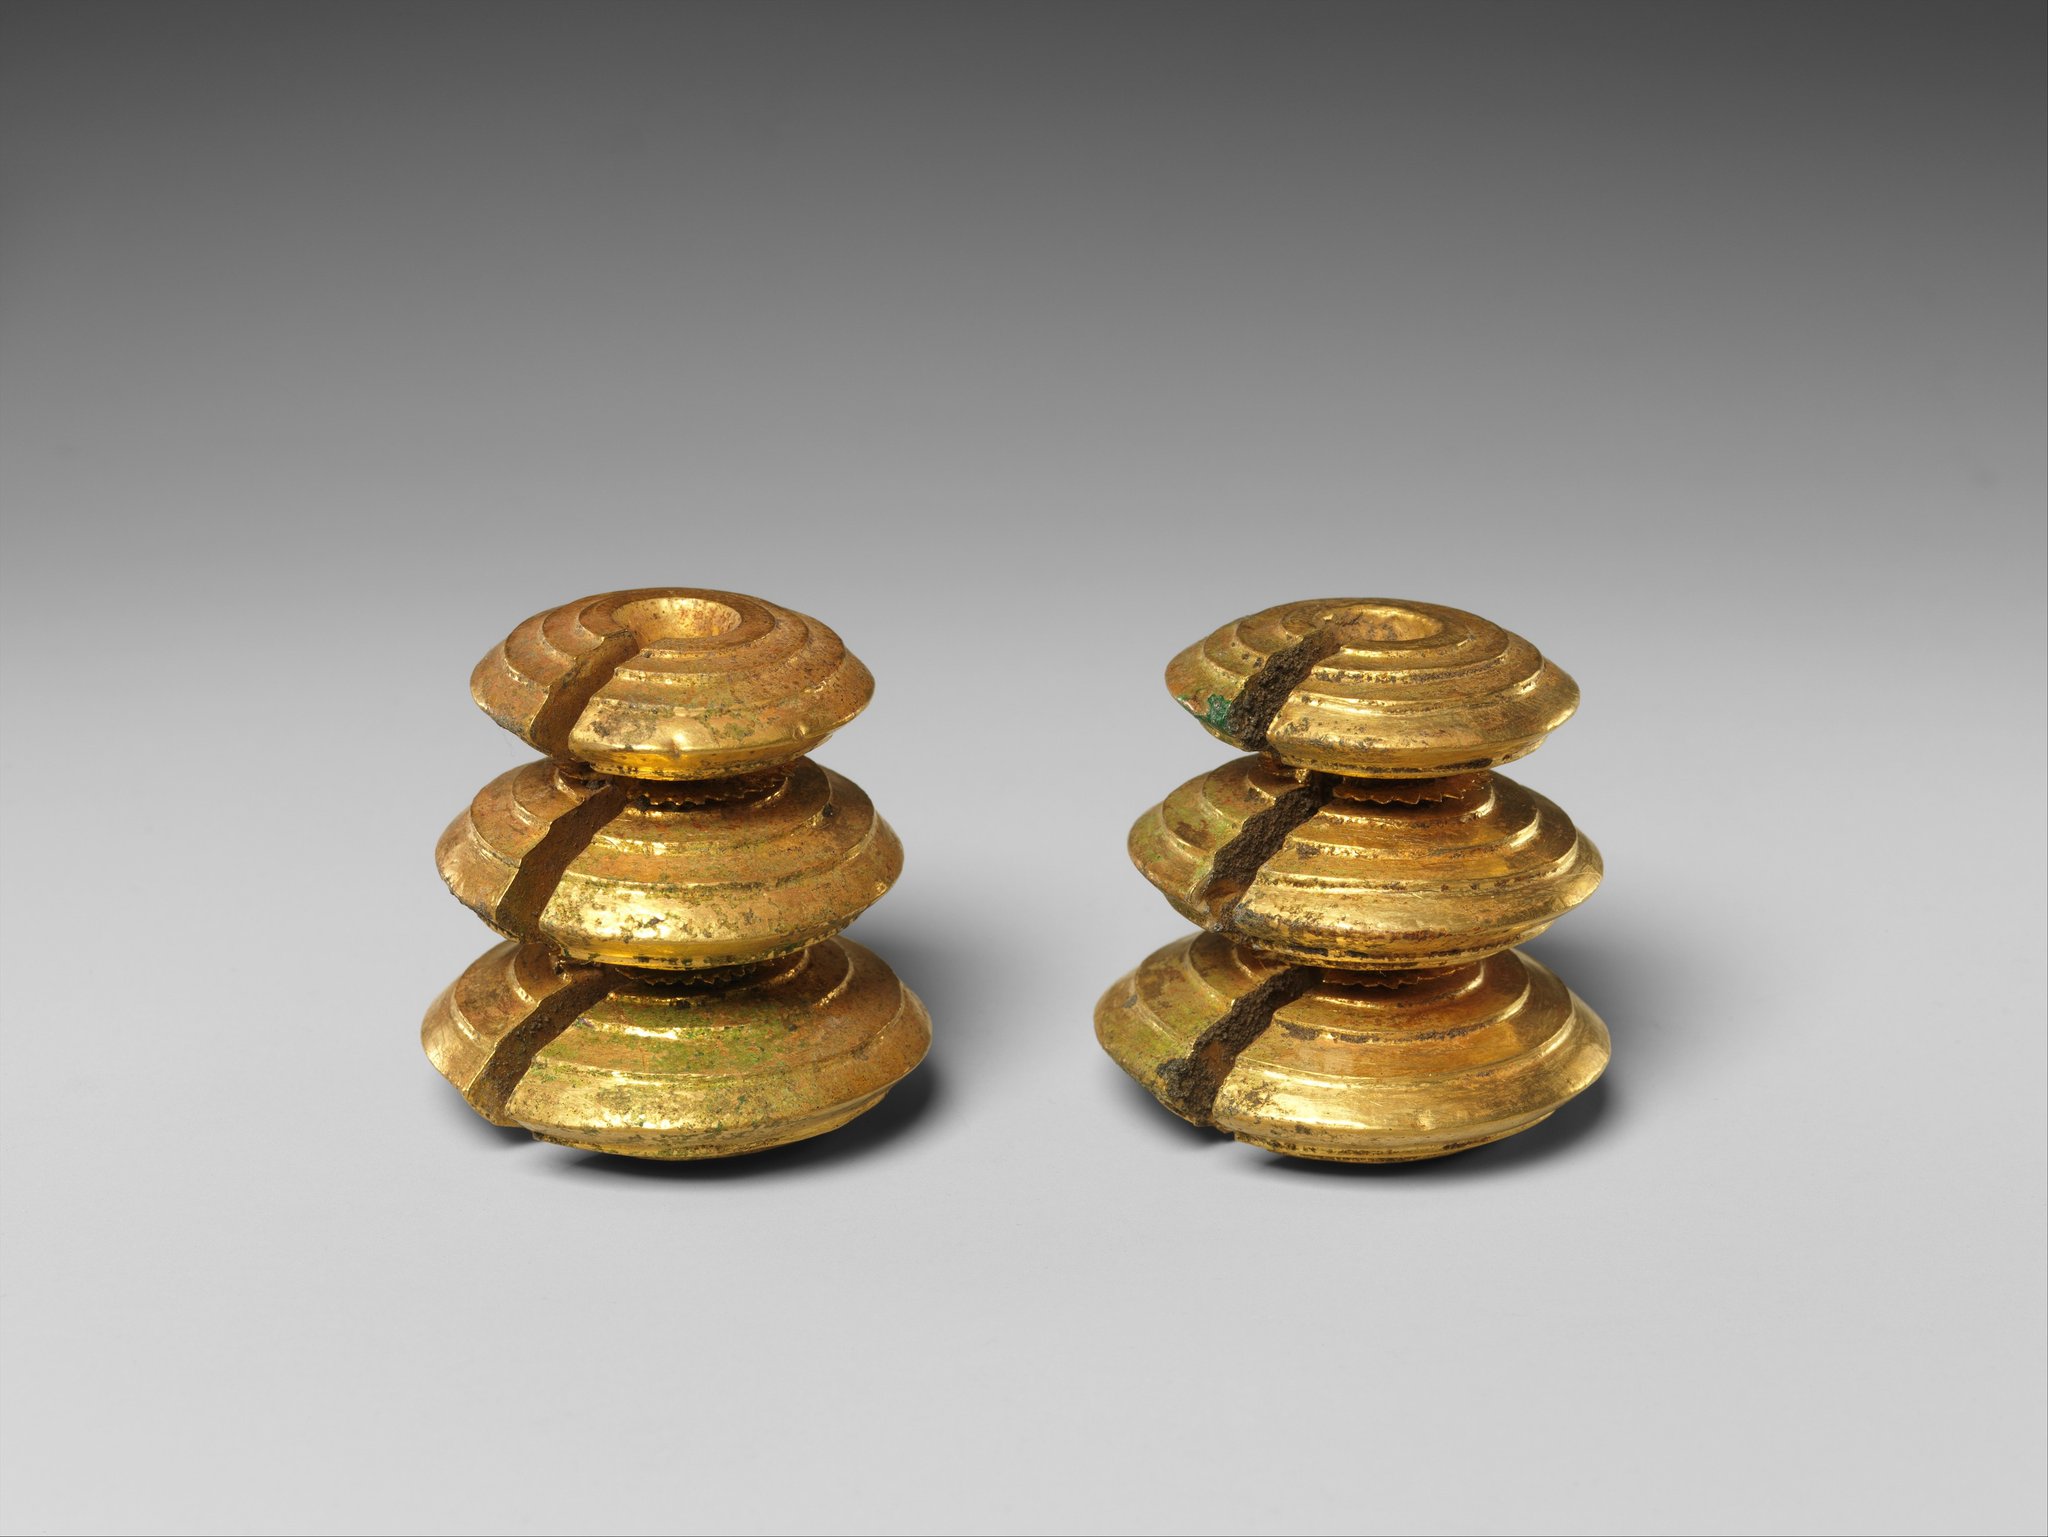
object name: fastener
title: Pair of Weighted Fasteners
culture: indonesian, javanese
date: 701-933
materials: gold